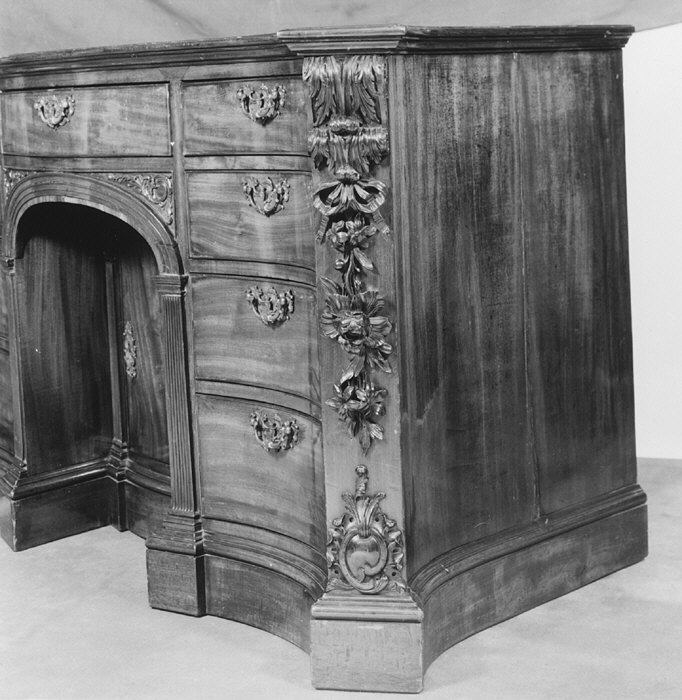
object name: kneehole writing table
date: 1755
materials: gilt bronze, wood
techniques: veneering